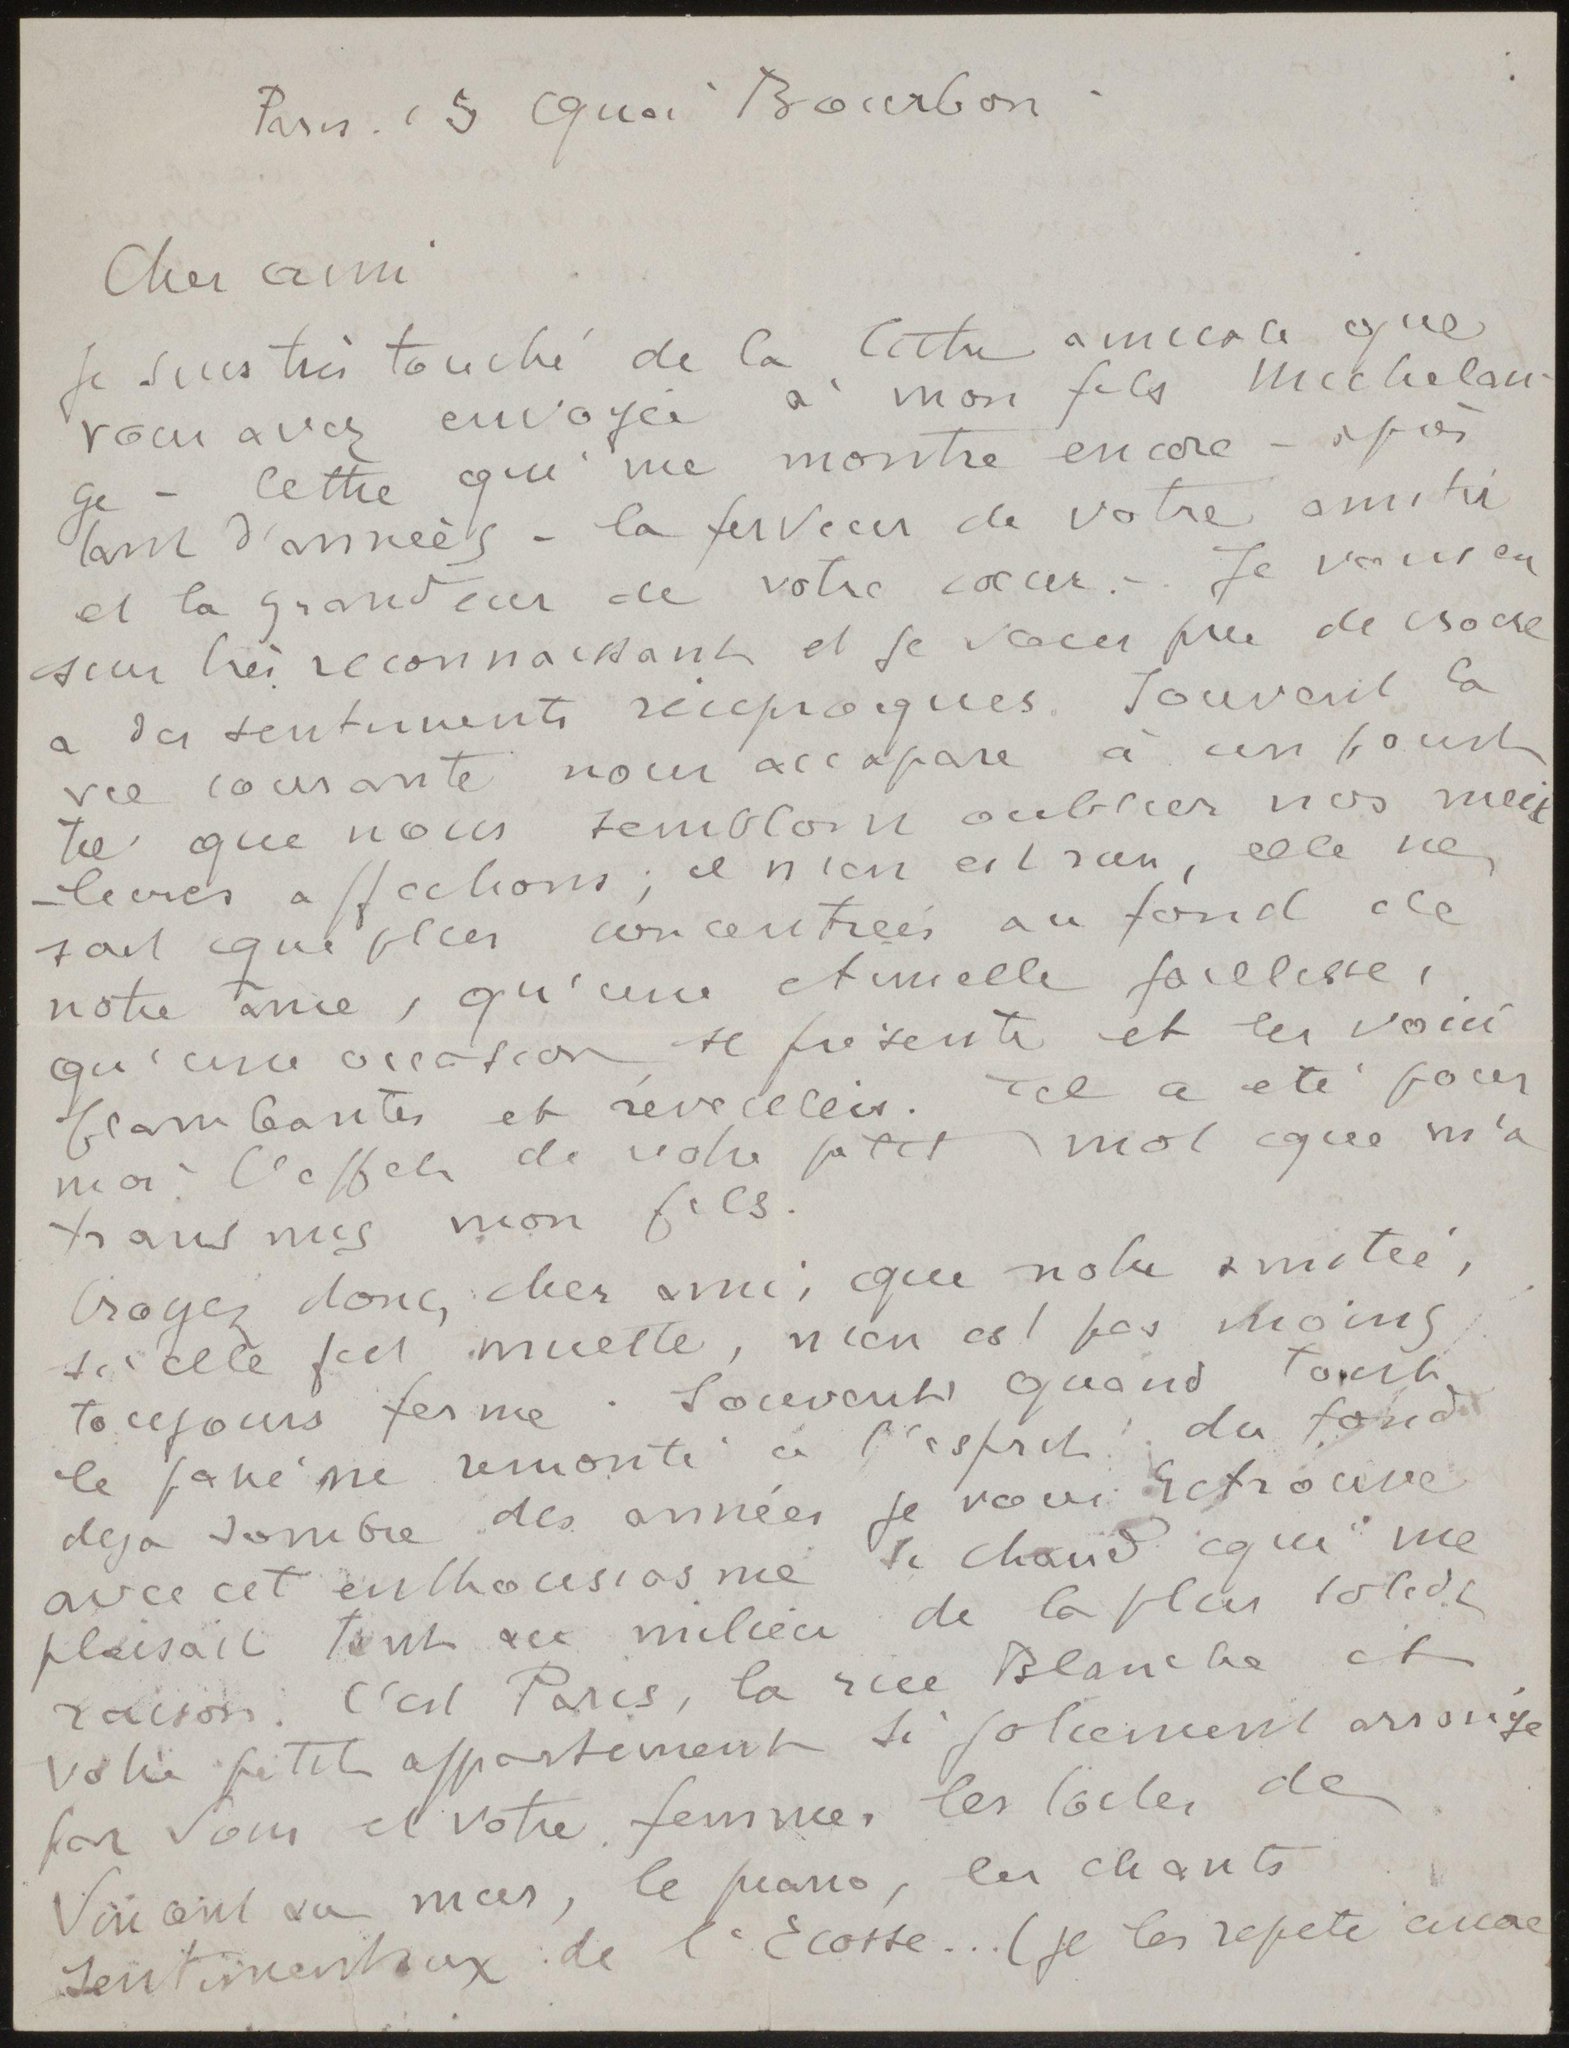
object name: letter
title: Brief aan Andries Bonger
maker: émile bernard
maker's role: print maker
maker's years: 1868-1941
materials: ink, paper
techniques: pen, writing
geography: paris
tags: michel ange bernard, paris, odilon redon, painter, print maker, draughtsman, vincent van gogh, paul cézanne, amsterdam, andries bonger, johanna bonger, applied arts, arts and crafts; industrial design, family life, exhibition ~ art, italy, venice, rome